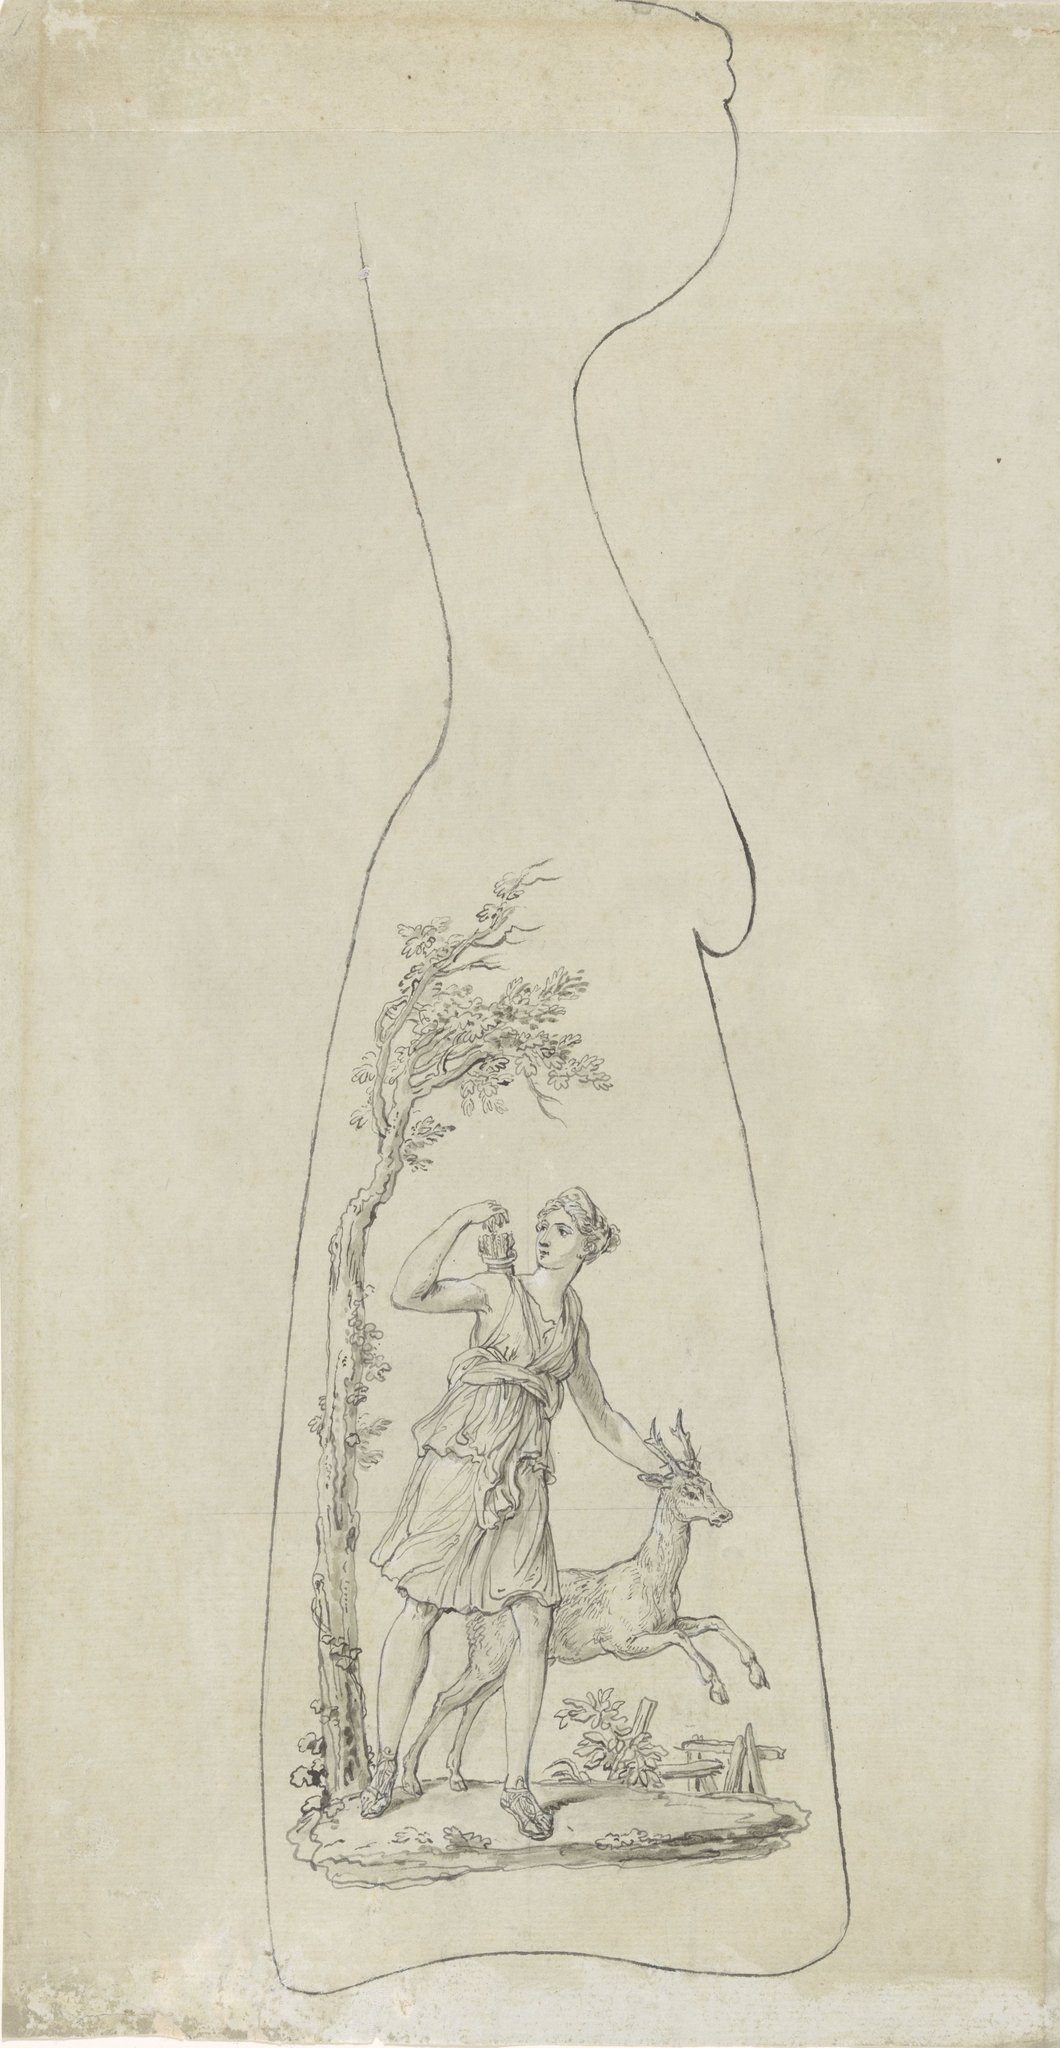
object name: design drawing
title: Ontwerp voor het inlegwerk van de kolf van een geweer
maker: françois lucas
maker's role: print maker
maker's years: 1715-1762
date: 1790-1800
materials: graphite, ink, paper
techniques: brush, pen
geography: paris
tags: diana hunting, firearms: rifle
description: De omtreklijnen van het geweer en de aan de achterzijde weergegeven onderdelen van het wapen, getekend in grafiet, zijn vermoedelijk van een andere hand dan de tekening van het inlegwerk, uitgevoerd in pen en penseel.